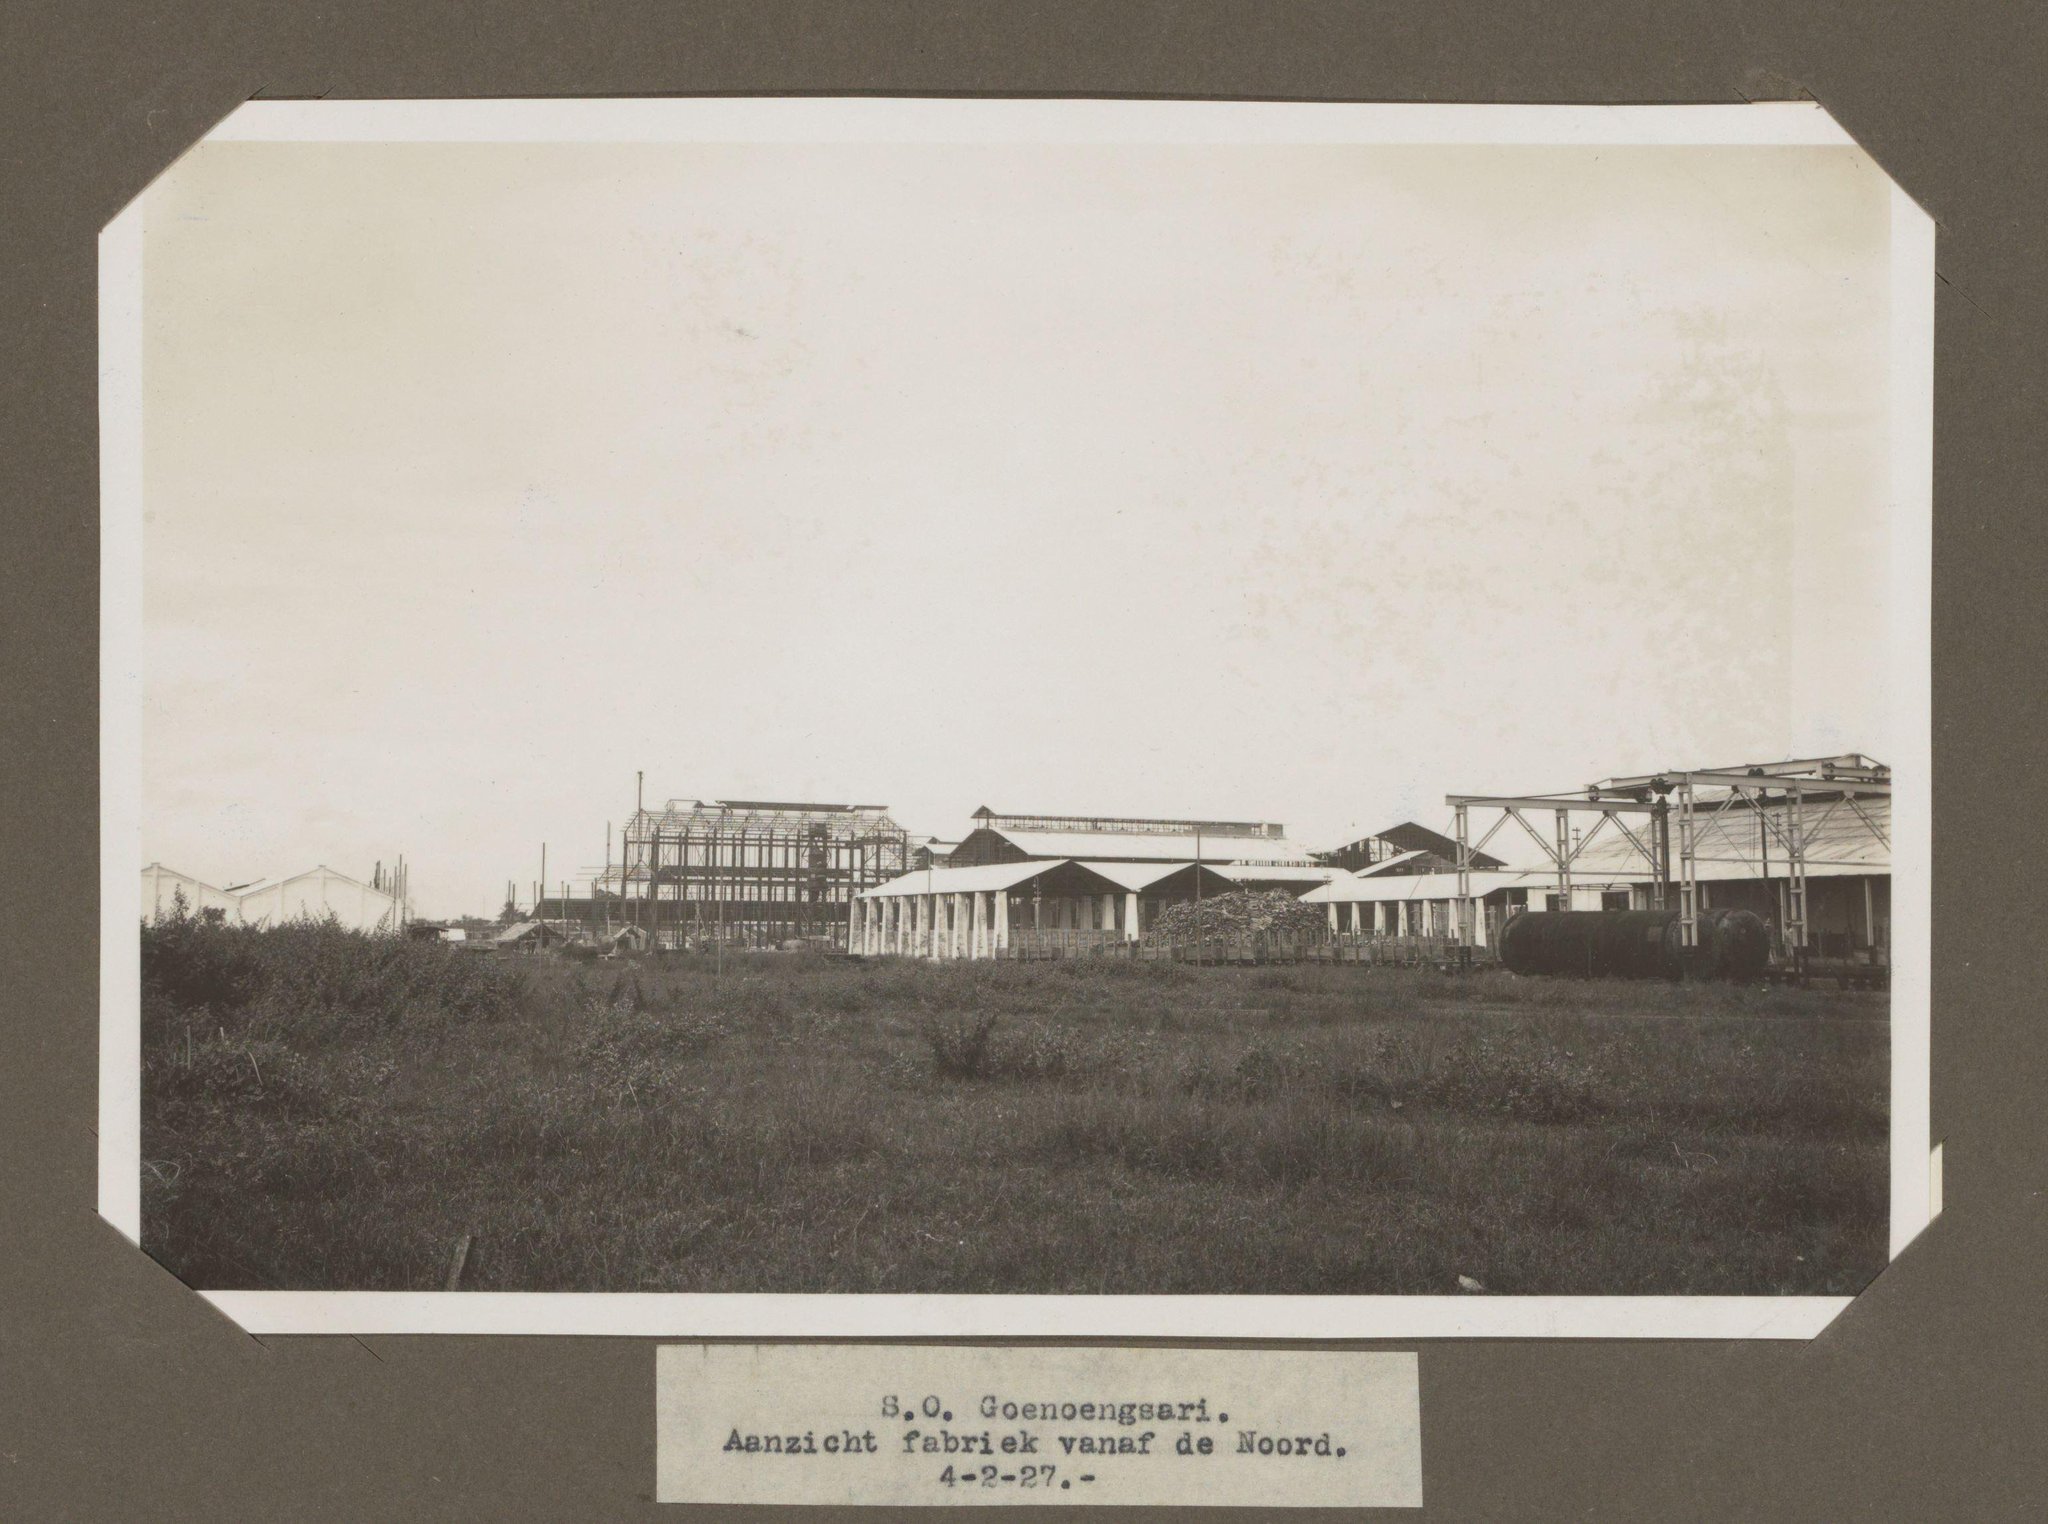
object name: photograph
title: S.O. Goenoengsari. Aanzicht fabriek vanaf de Noord. 4-2-27.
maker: Anonymous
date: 1902-1927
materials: photographic support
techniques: gelatin silver print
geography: east java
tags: colonial system, trade-company, making the overground structures (~ building activities), (non-fruit) products of plants or trees: sugarcane, exterior of industrial structures, factories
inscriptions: inscription: ‘S.O. Goenoengsari. Aanzicht fabriek vanaf de Noord. 4-2-27.’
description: Gezicht op de fabriek in aanbouw, 4 februari 1927. Onderdeel van het fotoalbum met foto's van de opbouw van de suikerfabriek te Goenoengsari op Oost-Java door de Handels Vereniging Amsterdam 1926-1927.